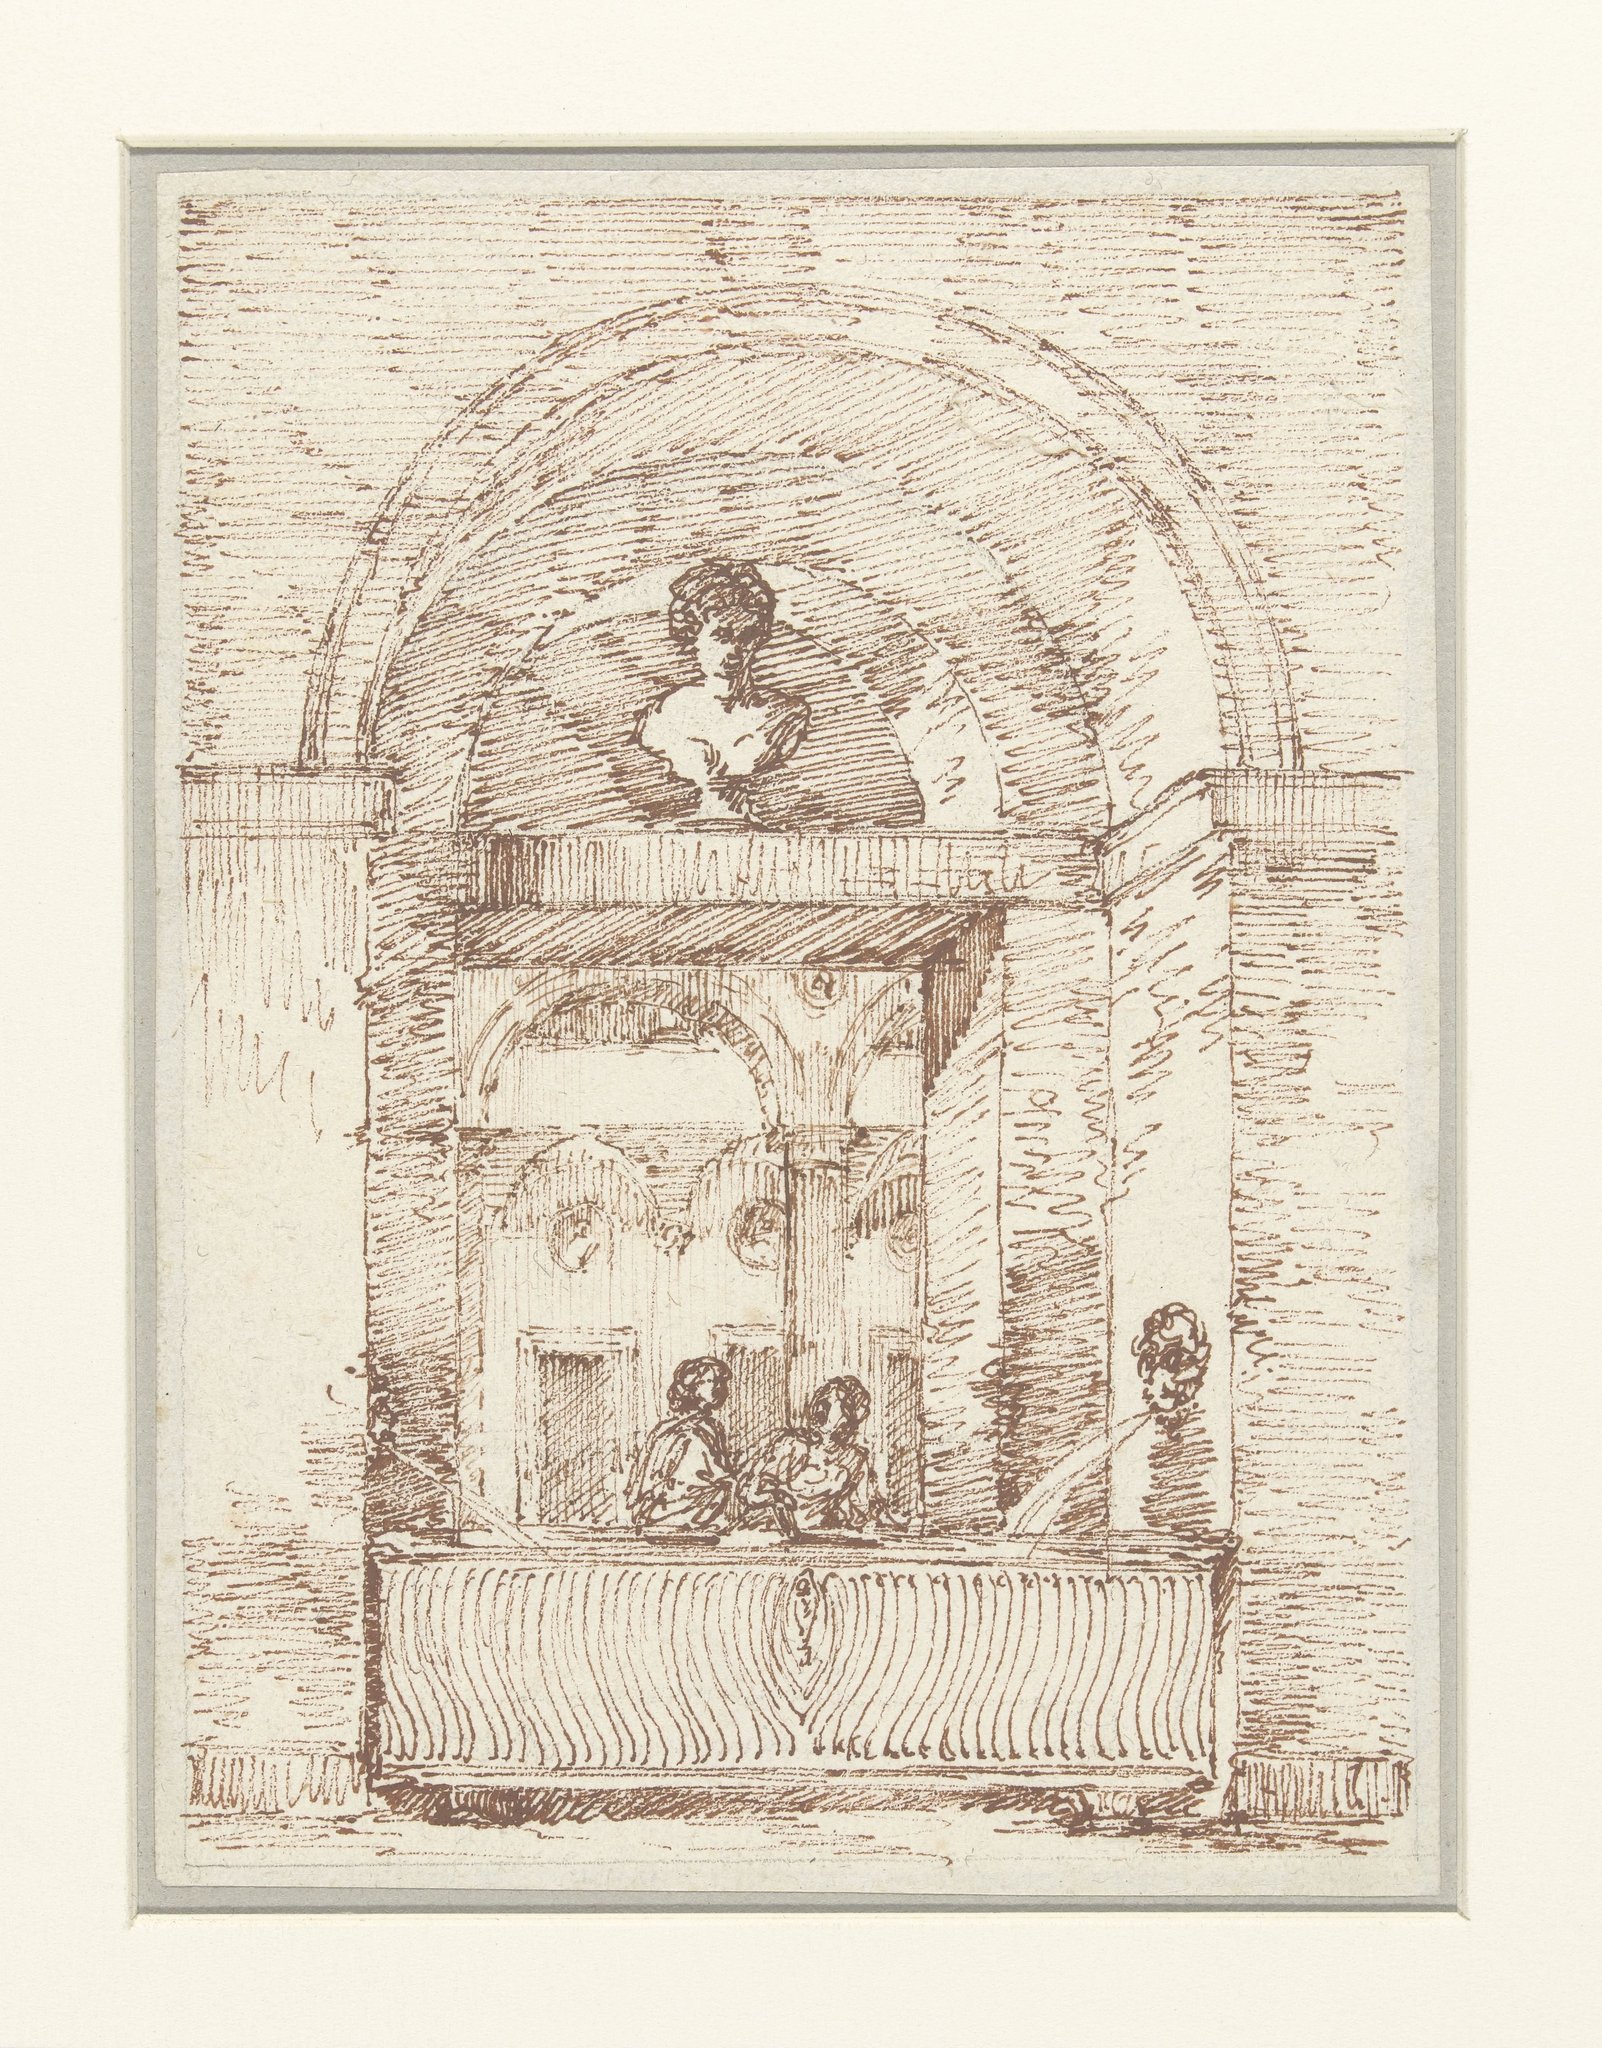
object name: drawing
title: Romeins portiek met twee vrouwen die water halen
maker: victor jean nicolle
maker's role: draughtsman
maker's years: 1754-1826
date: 1787-1811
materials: ink, paper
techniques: pen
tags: utilitarian, public pump or water fountain, rome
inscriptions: collector's mark, verso, lower centre: Lugt 2228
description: Een Romeins portiek, waaronder twee vrouwen water halen uit een sarcofaag; daarboven een antiek borstbeeld.